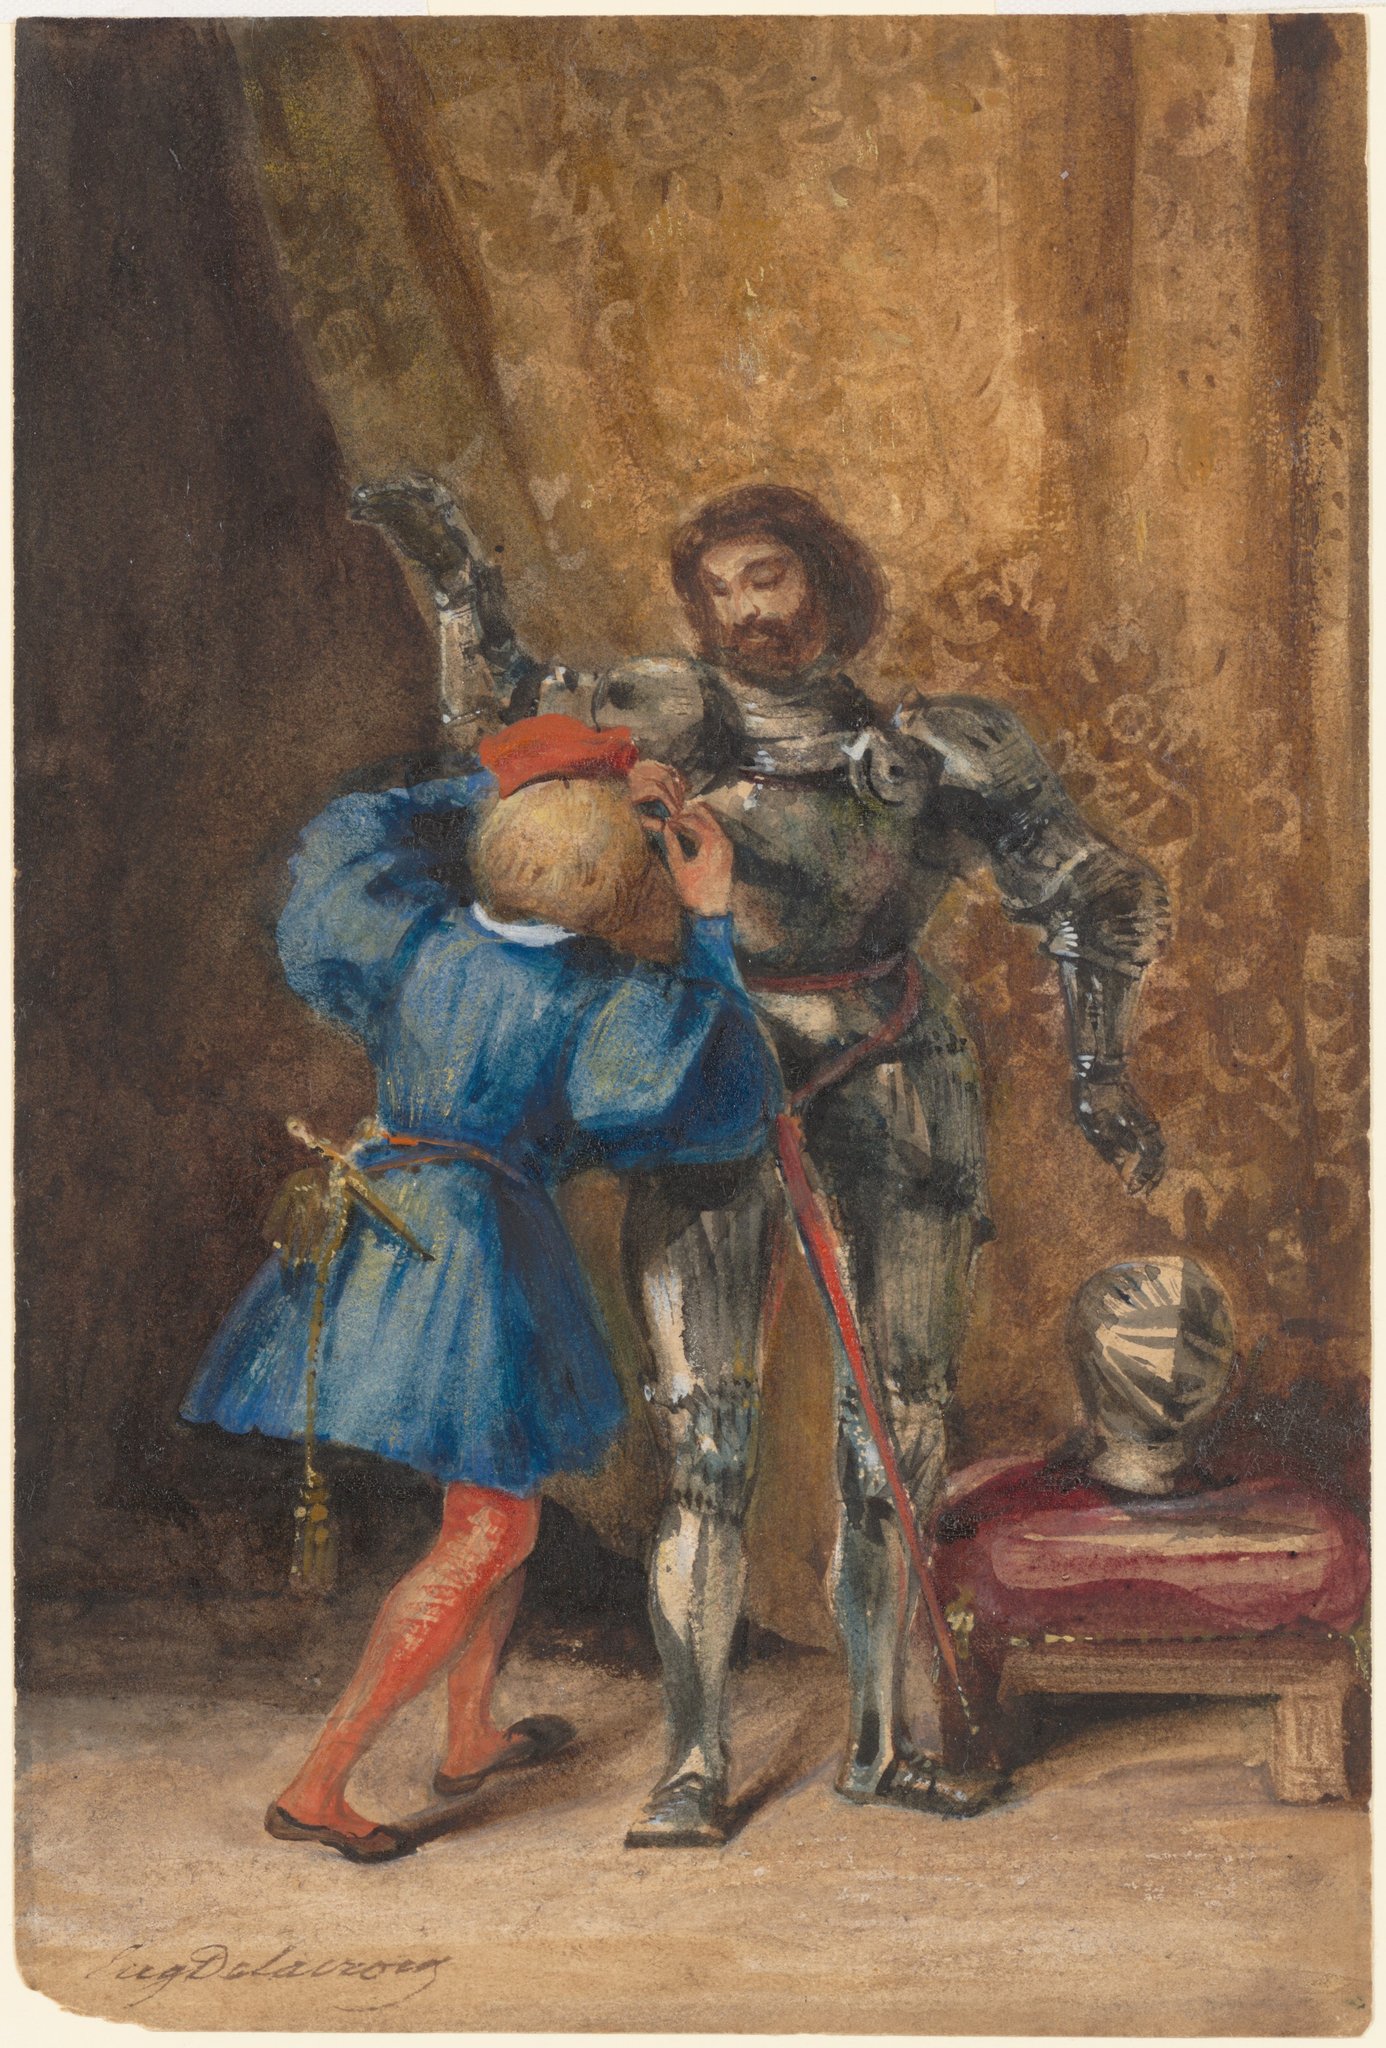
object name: drawing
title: Goetz von Berlichingen Being Dressed in Armor by His Page George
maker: eugène delacroix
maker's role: artist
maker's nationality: french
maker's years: 1798-1863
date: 1826-1827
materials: paint, gum arabic, watercolor, paper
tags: armor,men,dressing